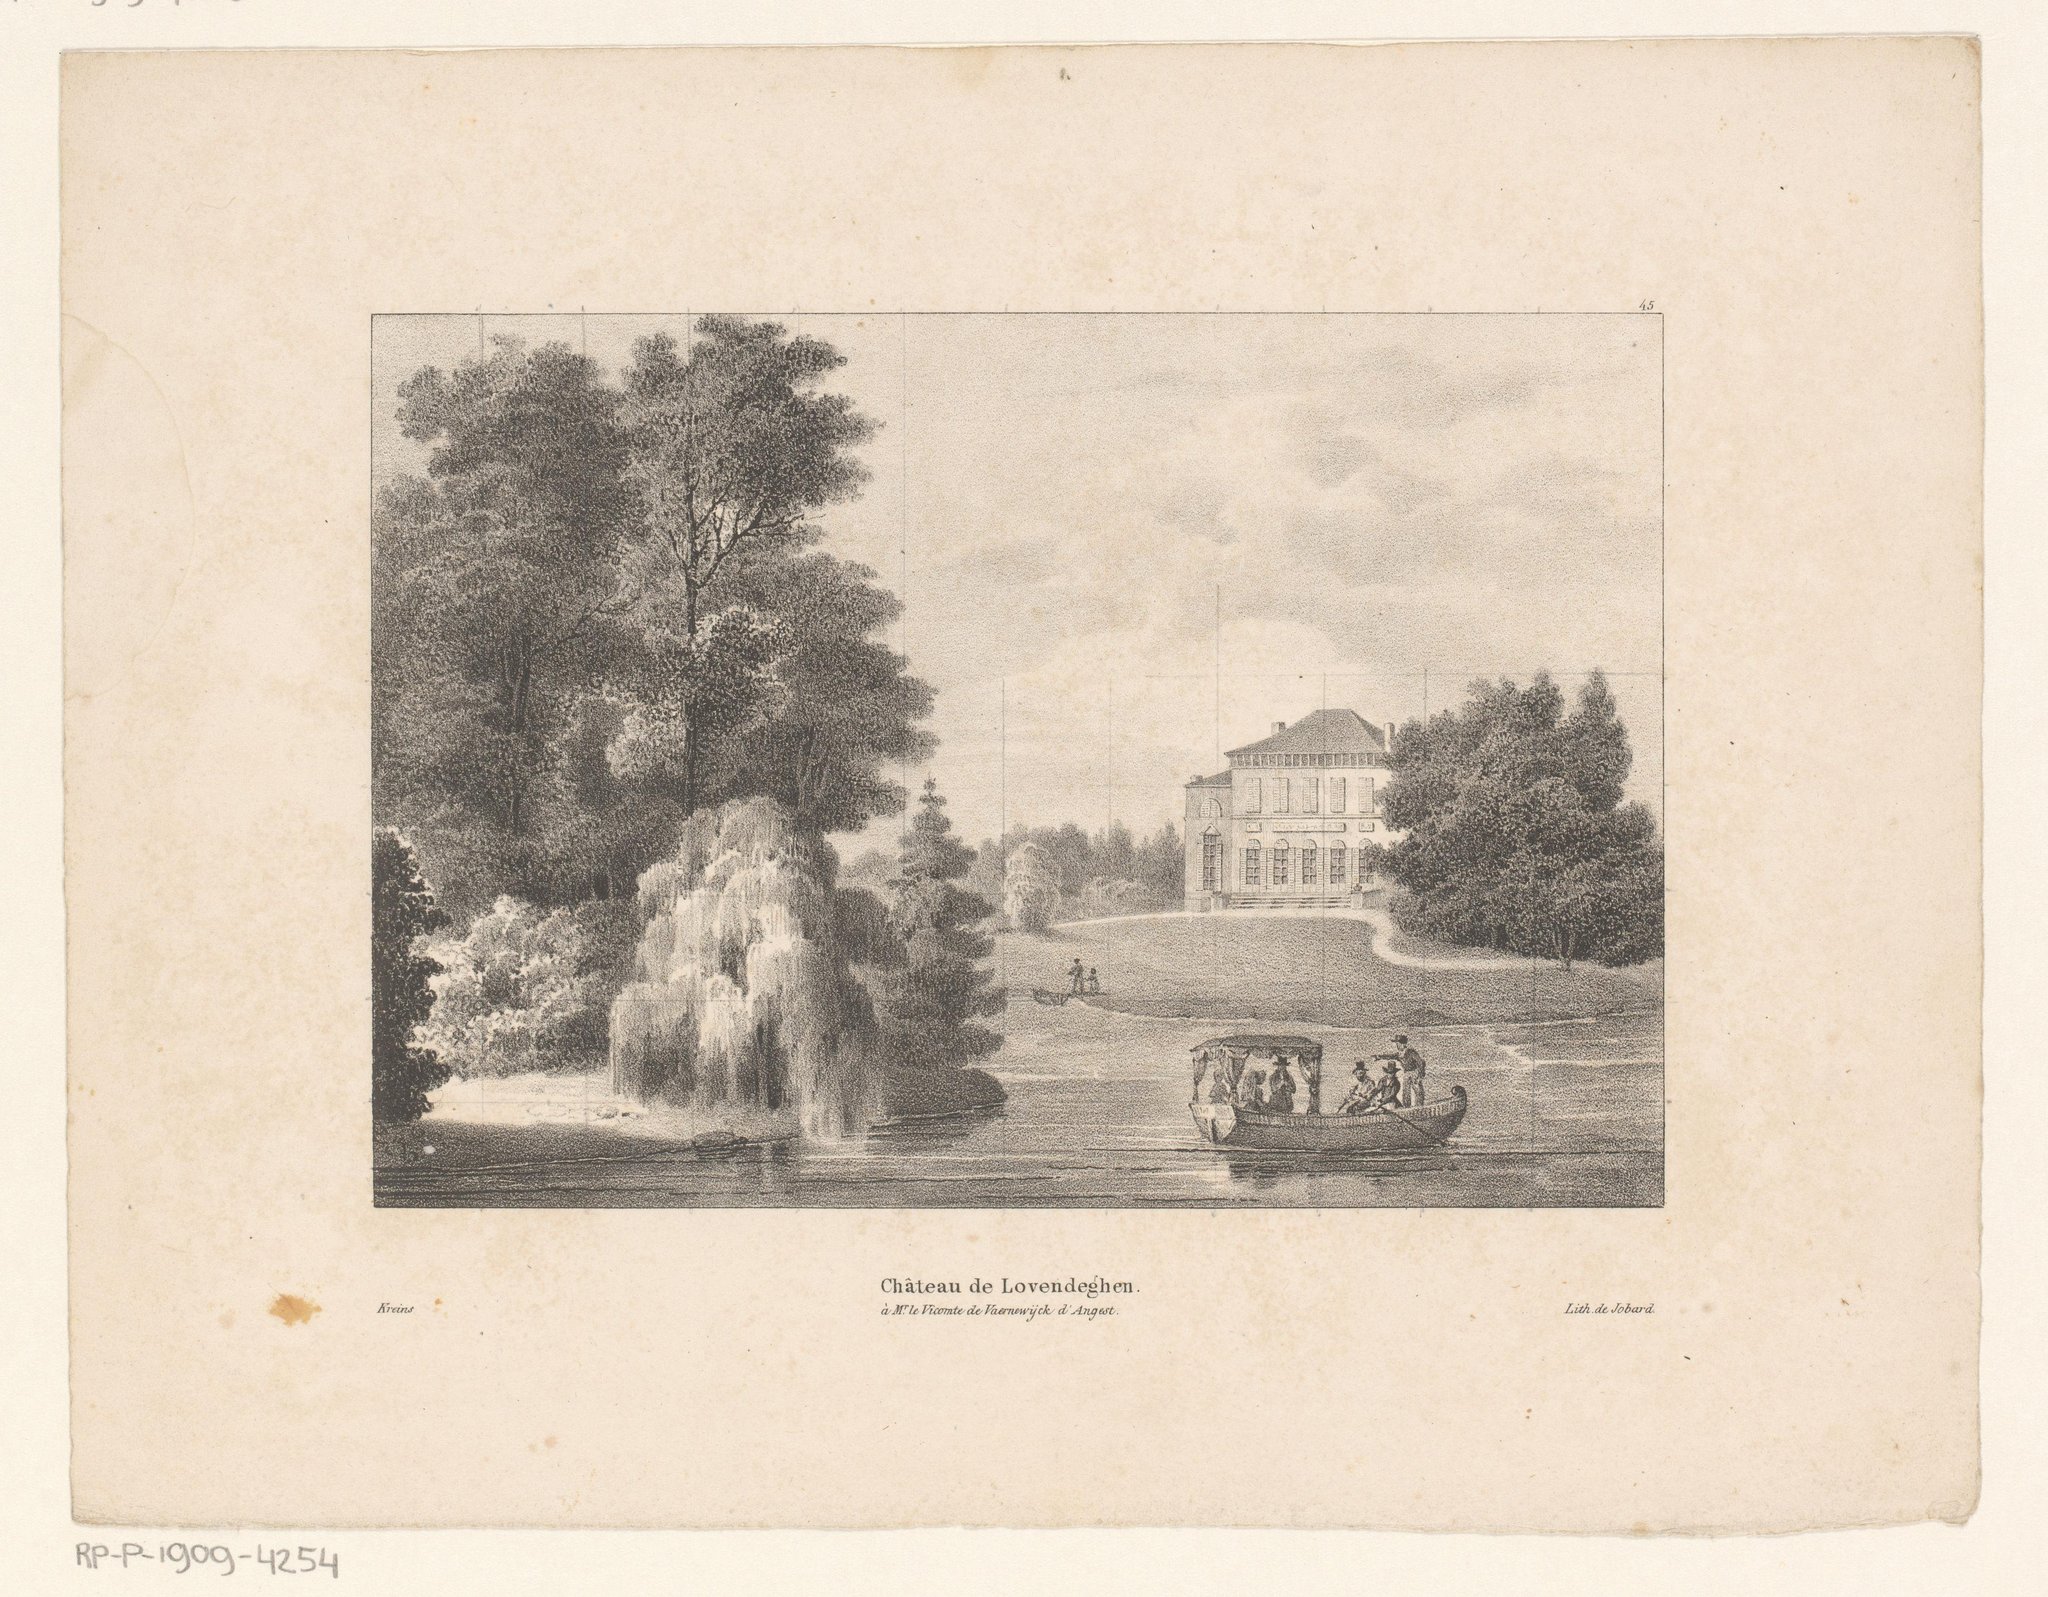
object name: print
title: Gezicht op kasteel Diepenbroeck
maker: hilaire antoine kreins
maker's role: print maker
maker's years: 1806-1862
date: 1827-1829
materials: paper, pencil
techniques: lithograph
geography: brussels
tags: castle, landscape with tower or castle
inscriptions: collector's mark: Lugt 2228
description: Prent verschenen in: Cloet, J.J. de. Châteaux et monumens des Pays-Bas faisant suite au voyage pittoresque. 2 dln. Brussel: Jobard frères, [1827-1829], dl. 1, nr. 45.